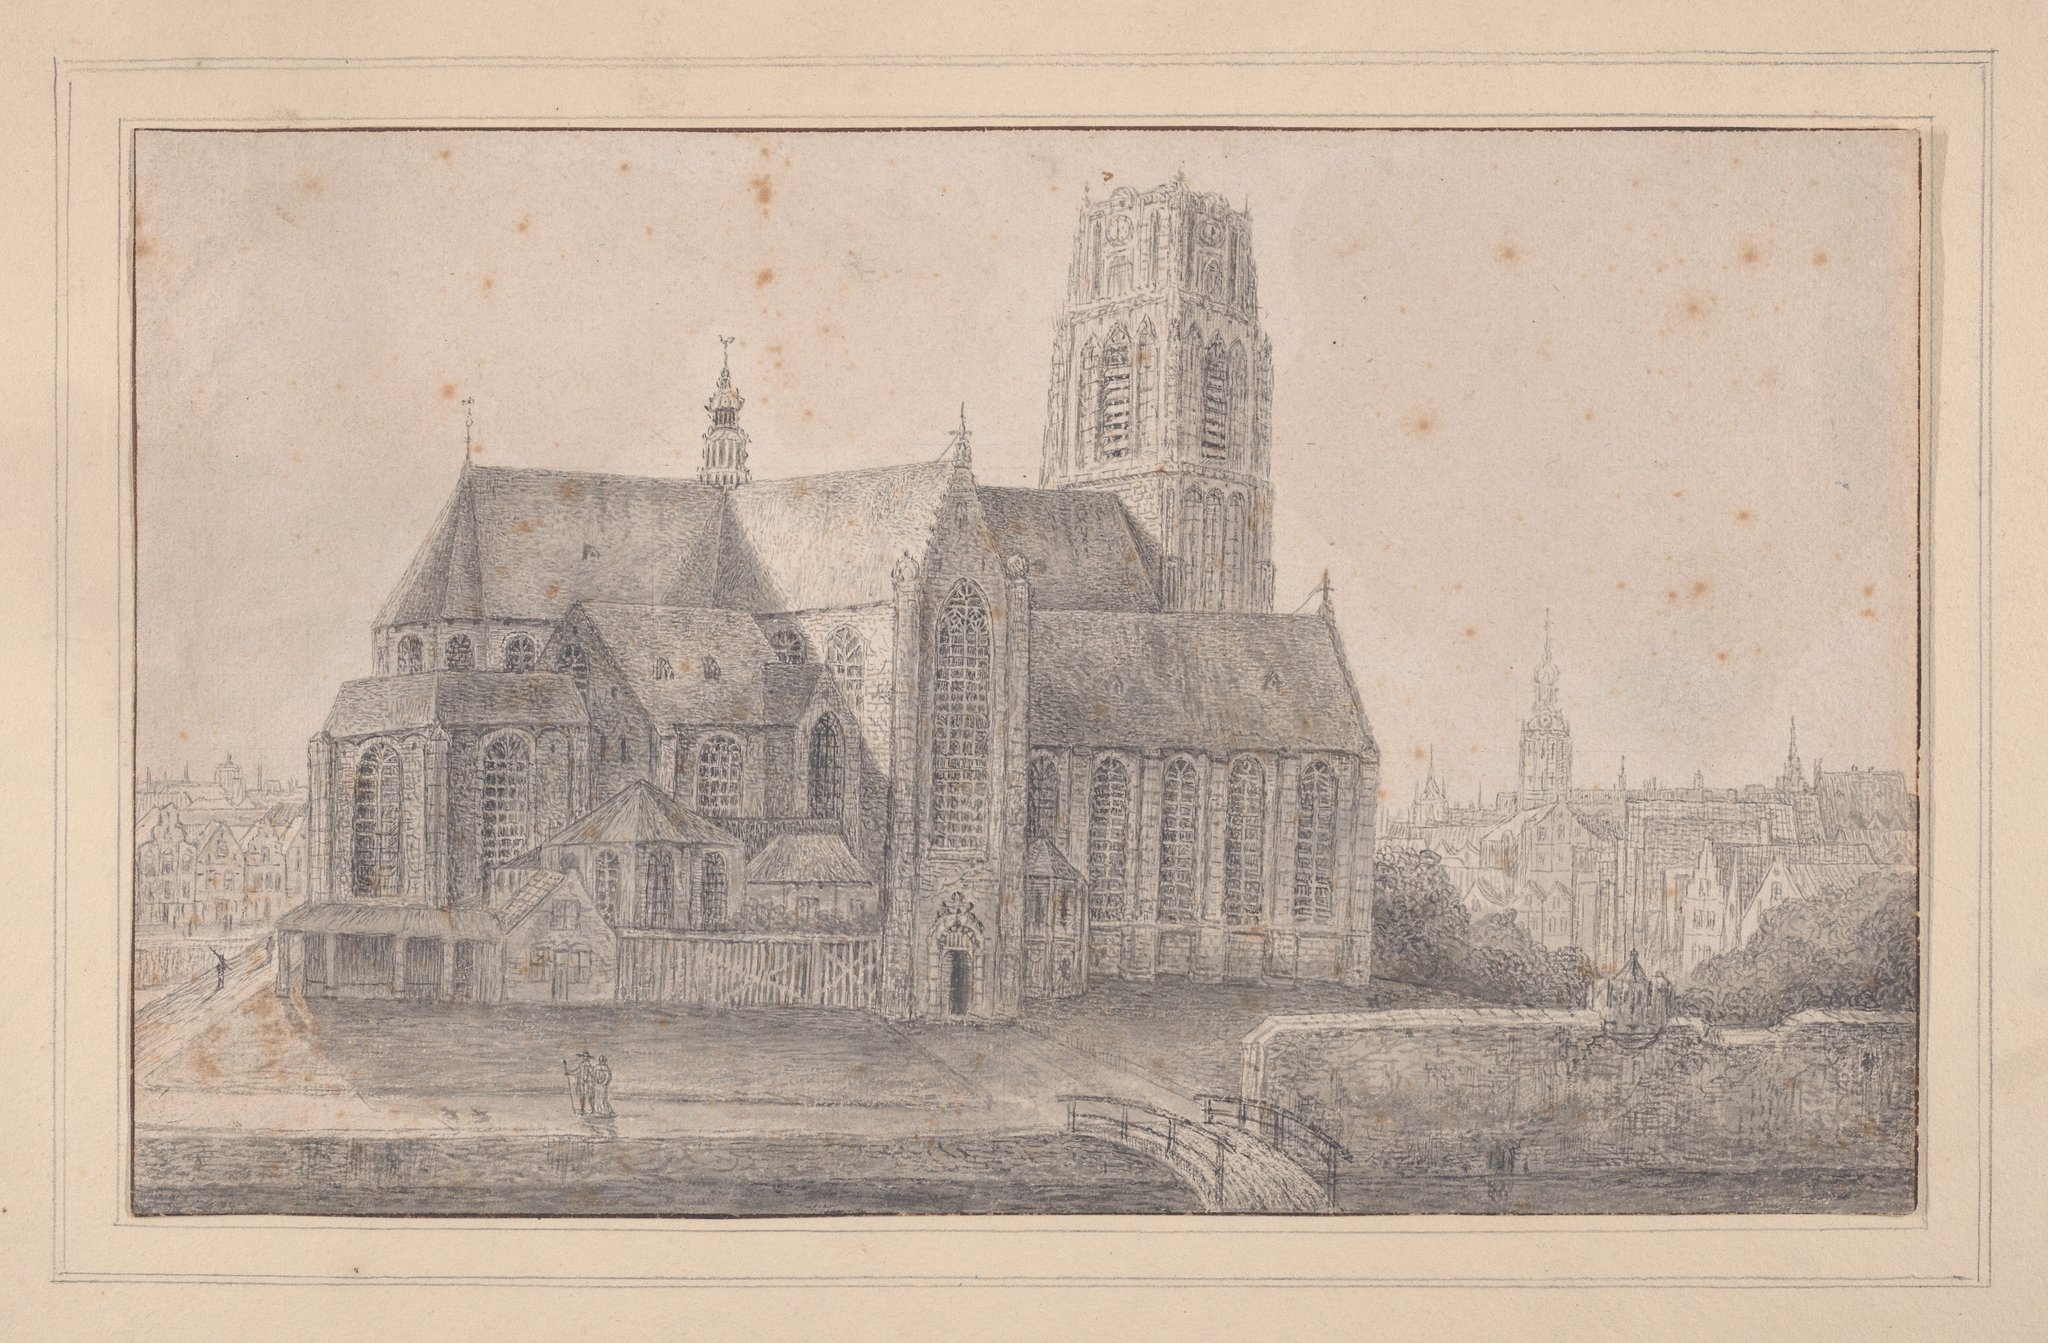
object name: drawing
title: View of the Laurenskerk, Rotterdam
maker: gerrit van battem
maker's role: artist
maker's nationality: dutch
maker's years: 1636-1684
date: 1701-1800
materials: ink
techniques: brush, pen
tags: churches